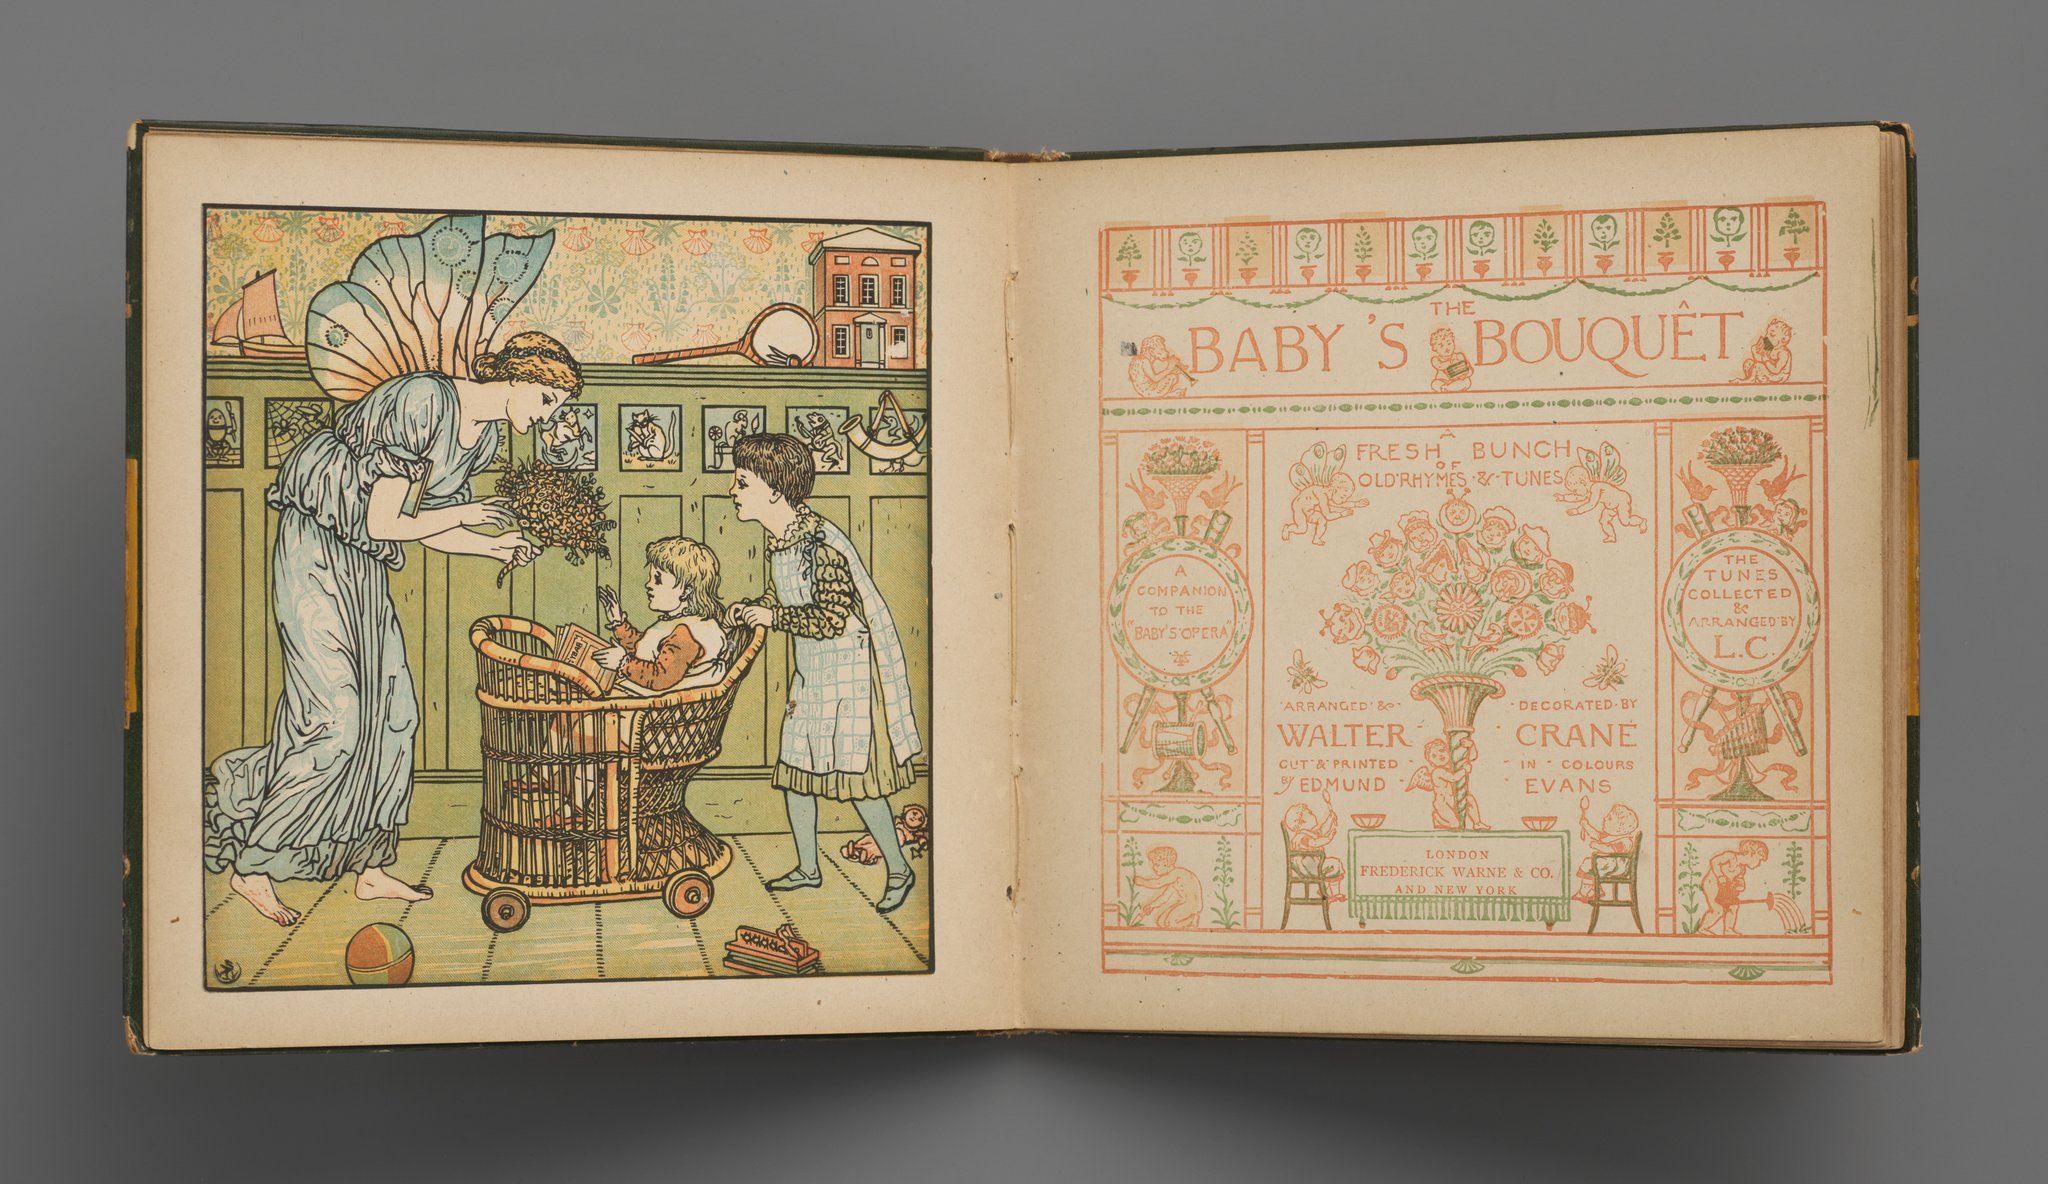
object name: book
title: The Baby's Bouquet, A Fresh Bunch of Rhymes and Tunes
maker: walter crane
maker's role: artist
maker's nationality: british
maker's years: 1845-1915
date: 1878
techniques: engraving